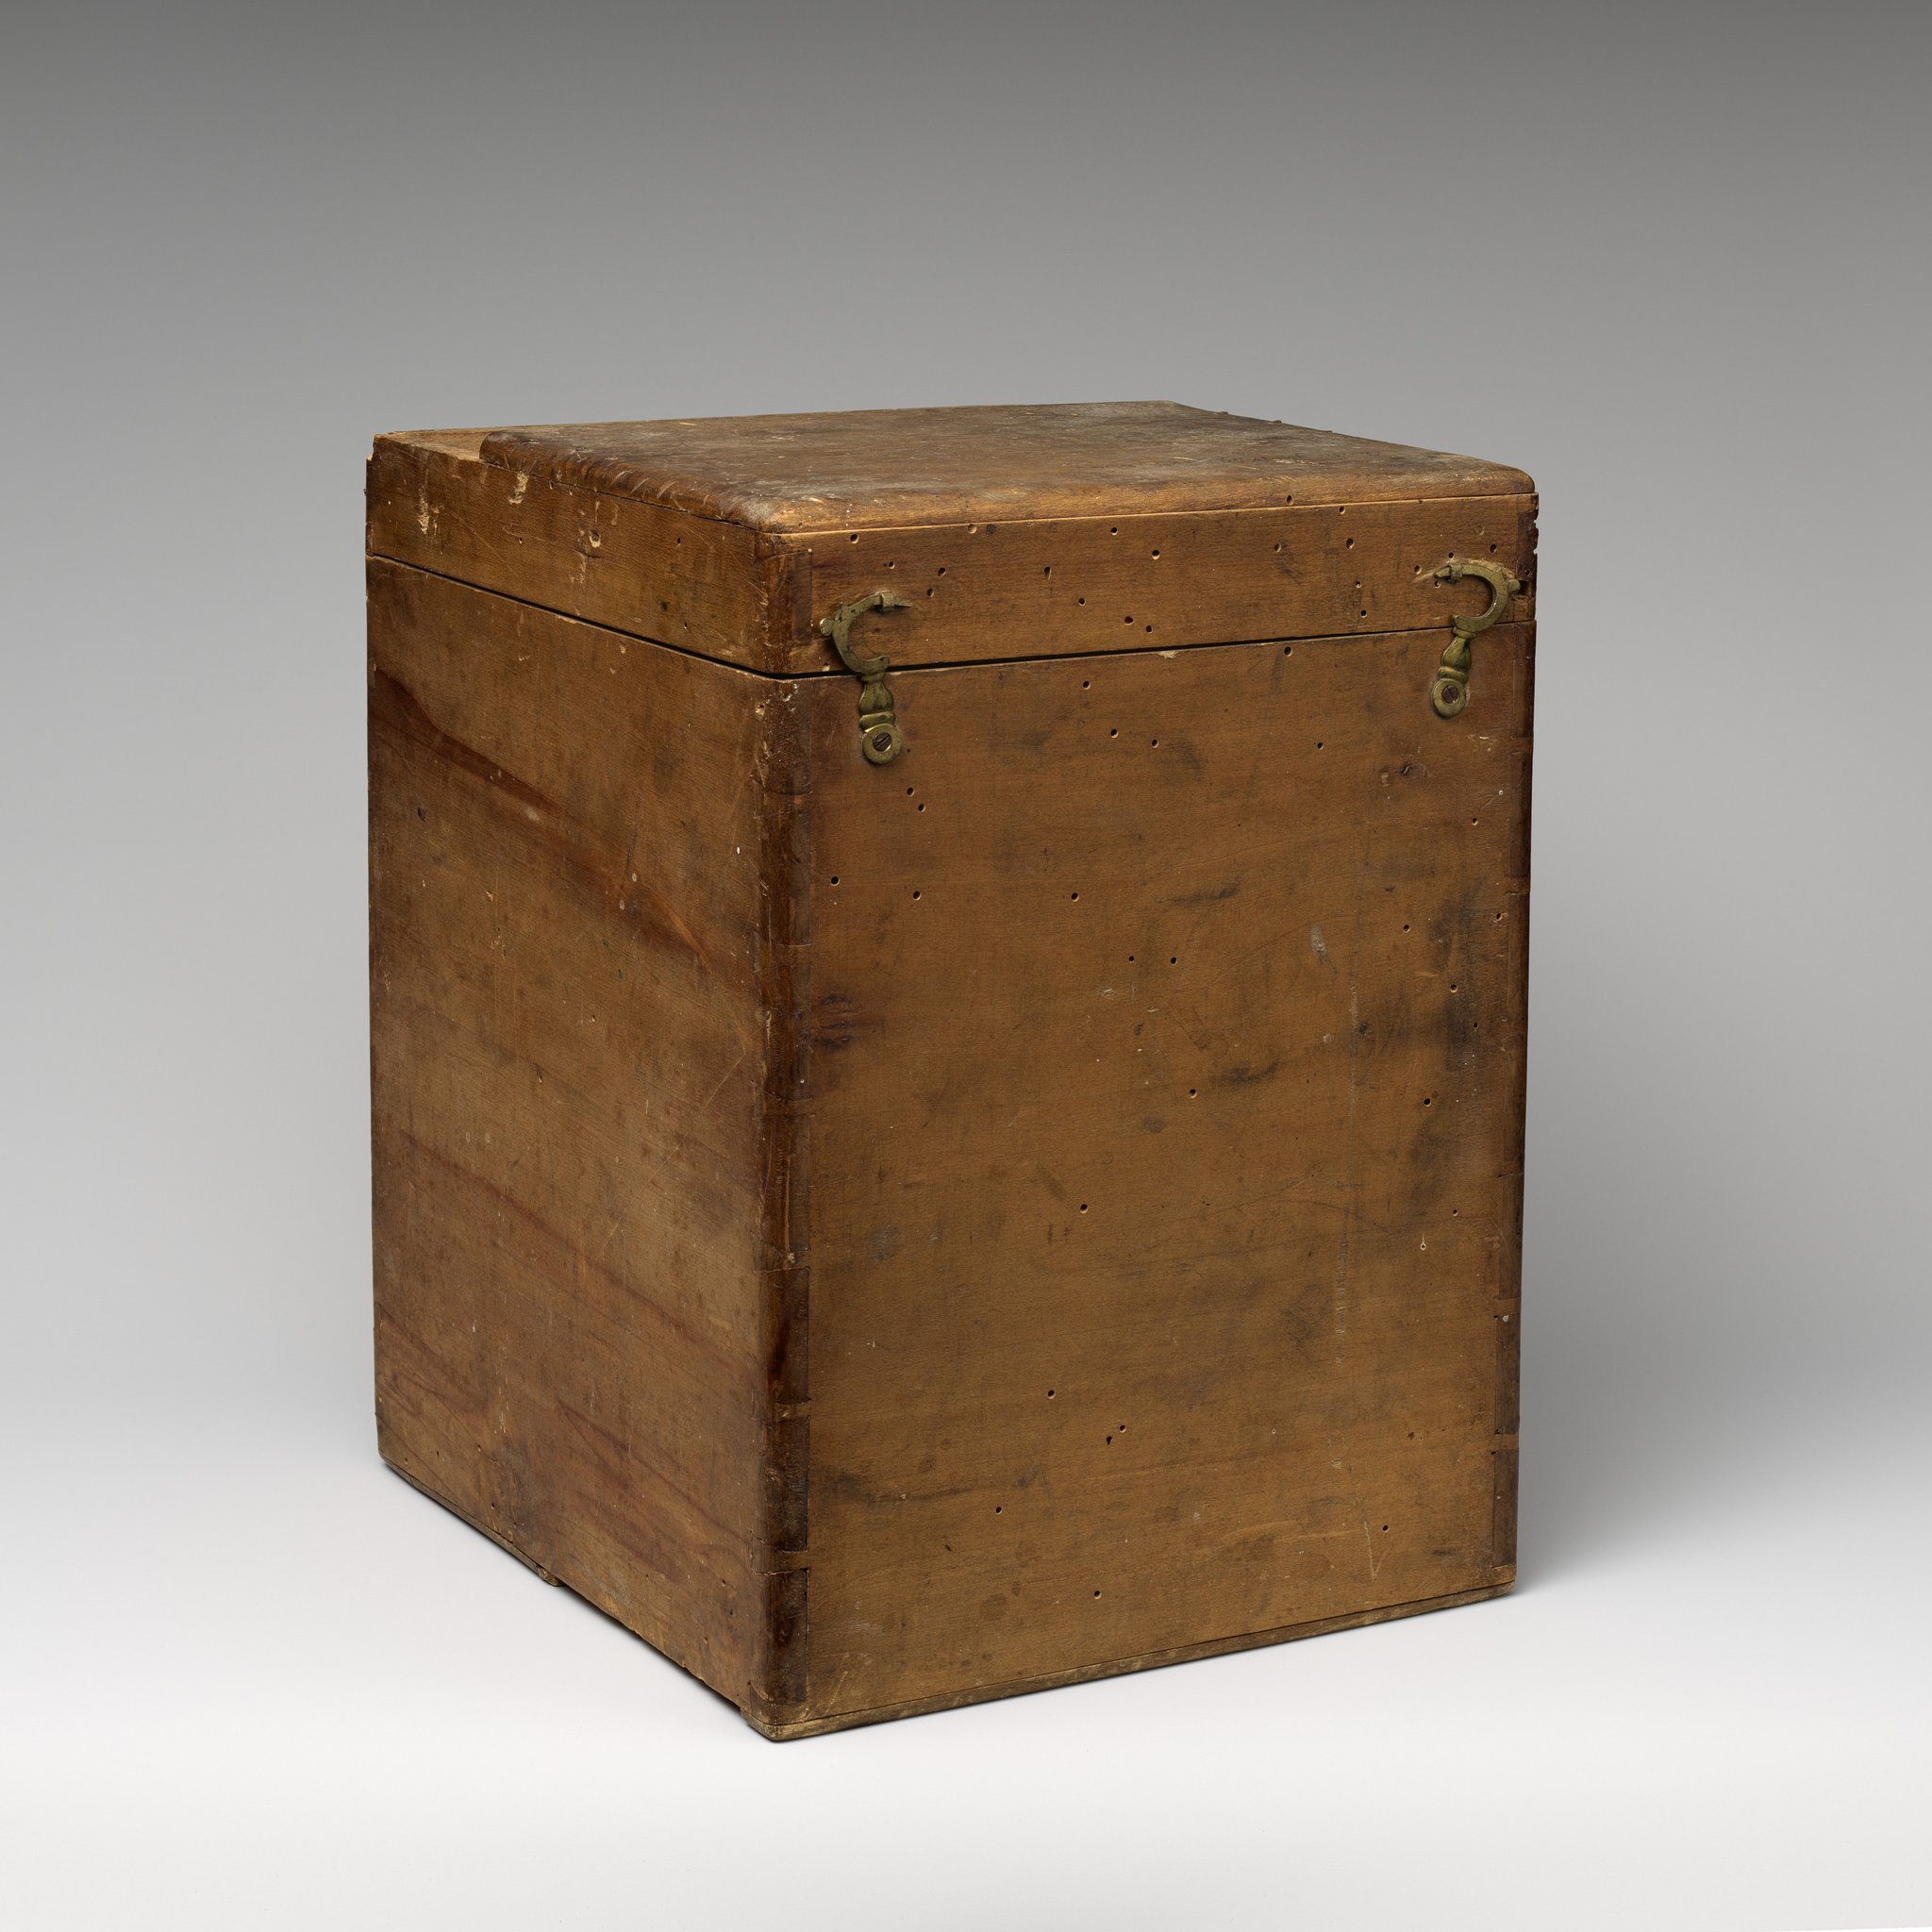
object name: box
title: [Daguerreotype Plate Box]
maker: Anonymous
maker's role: maker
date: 1840-1849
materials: ink, iron, wood